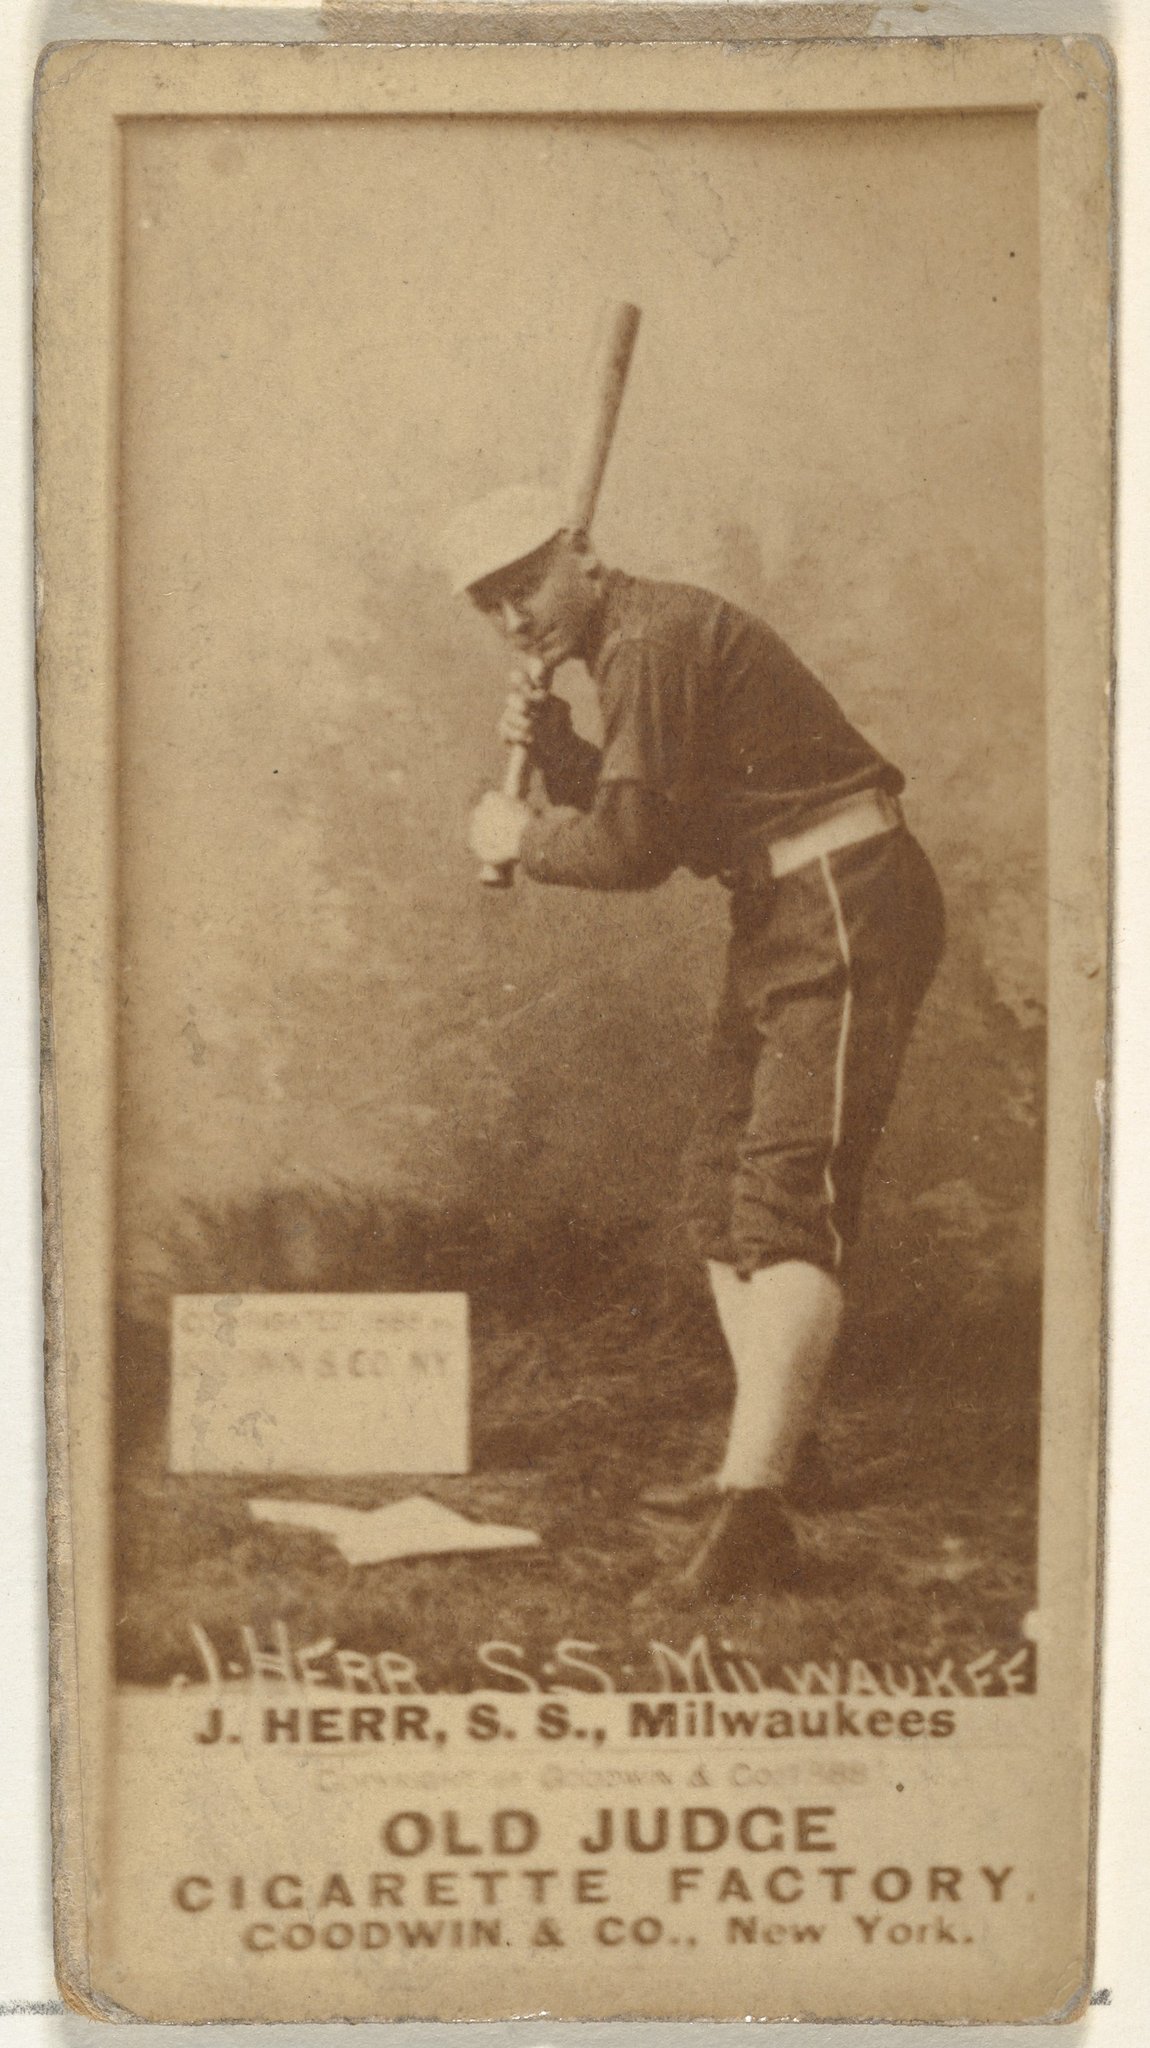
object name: baseball card, photograph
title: Joseph Herr, Shortstop, Milwaukee, from the Old Judge series (N172) for Old Judge Cigarettes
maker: goodwin & company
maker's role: publisher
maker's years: 1850-1950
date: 1888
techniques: albumen silver print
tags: men,portraits,baseball,athletes